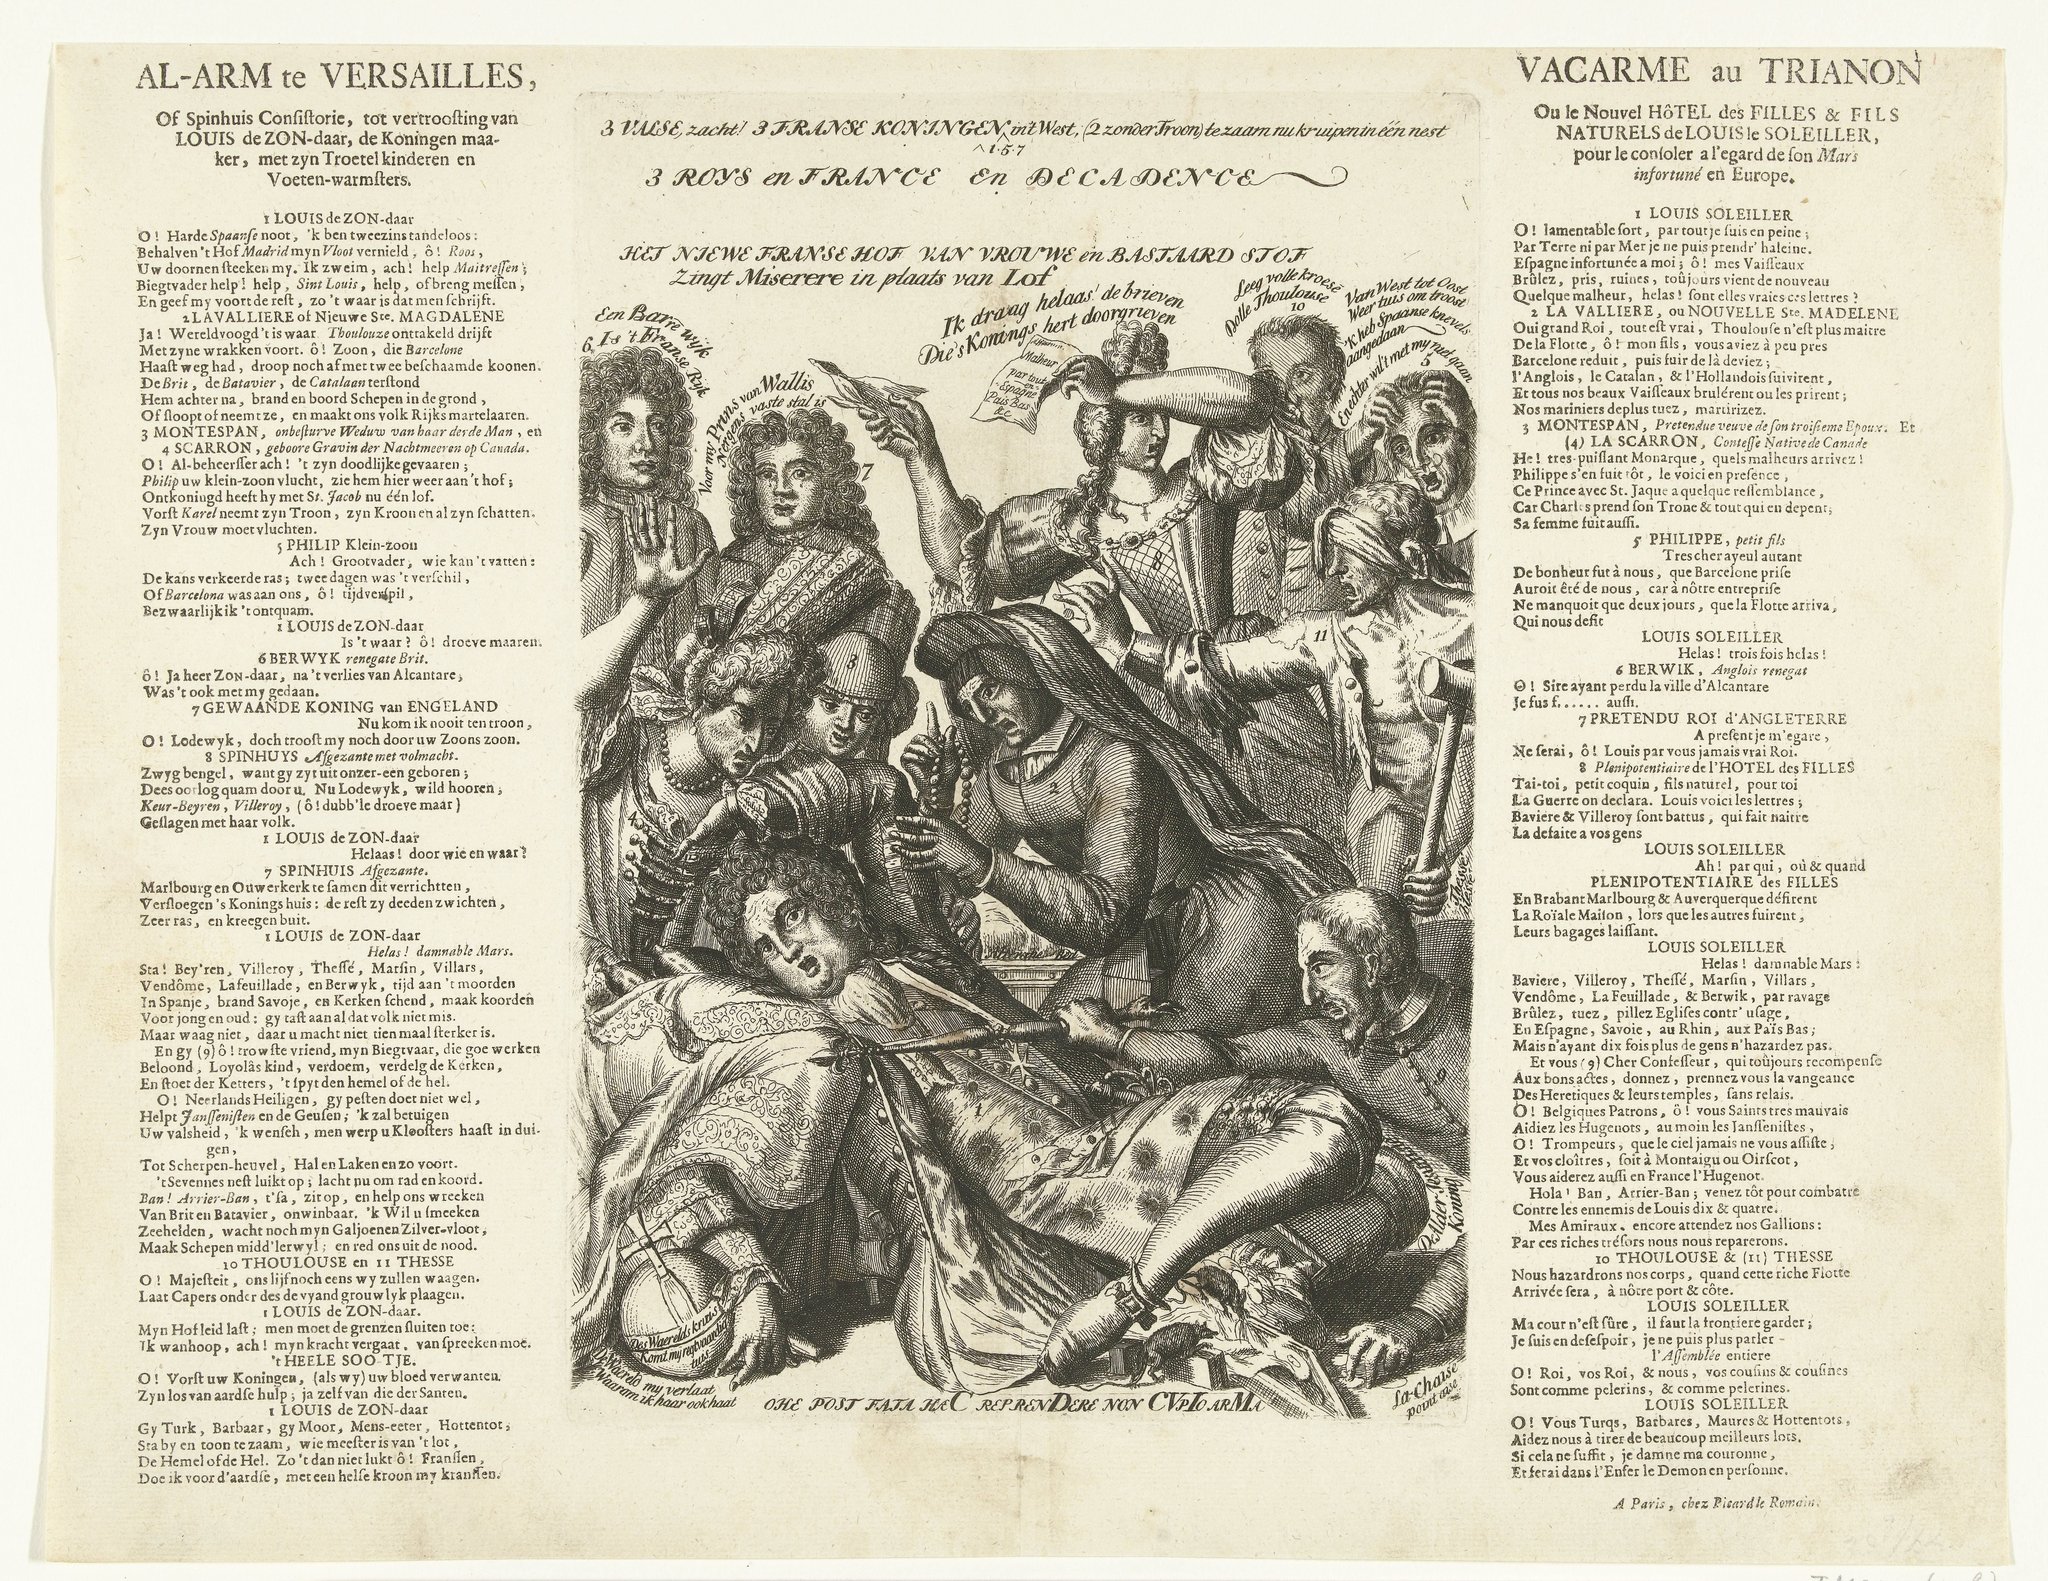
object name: print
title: Koninklijke Almanach van 1706 / 't Lusthof van Momus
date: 1706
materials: paper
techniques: etching, letterpress printing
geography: northern netherlands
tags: lodewijk xiv (koning van frankrijk), paris, madame de maintenon, françoise-athénaïs (marquise de montespan), political caricatures and satires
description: Spotprent op de Franse koning Lodewijk XIV die ziek wordt na het eten van te harde Spaanse noten, 1706. De maîtresses buigen zich over de koning. Aan weerszijden van de plaat tekst in 2 kolommen in het Nederlands en Frans. Spotprent op de situatie in het jaar 1706 in de Spaanse Successieoorlog. Onderdeel van een reeks van 25 spotprenten op de Fransen en bondgenoten uit het jaar 1706.